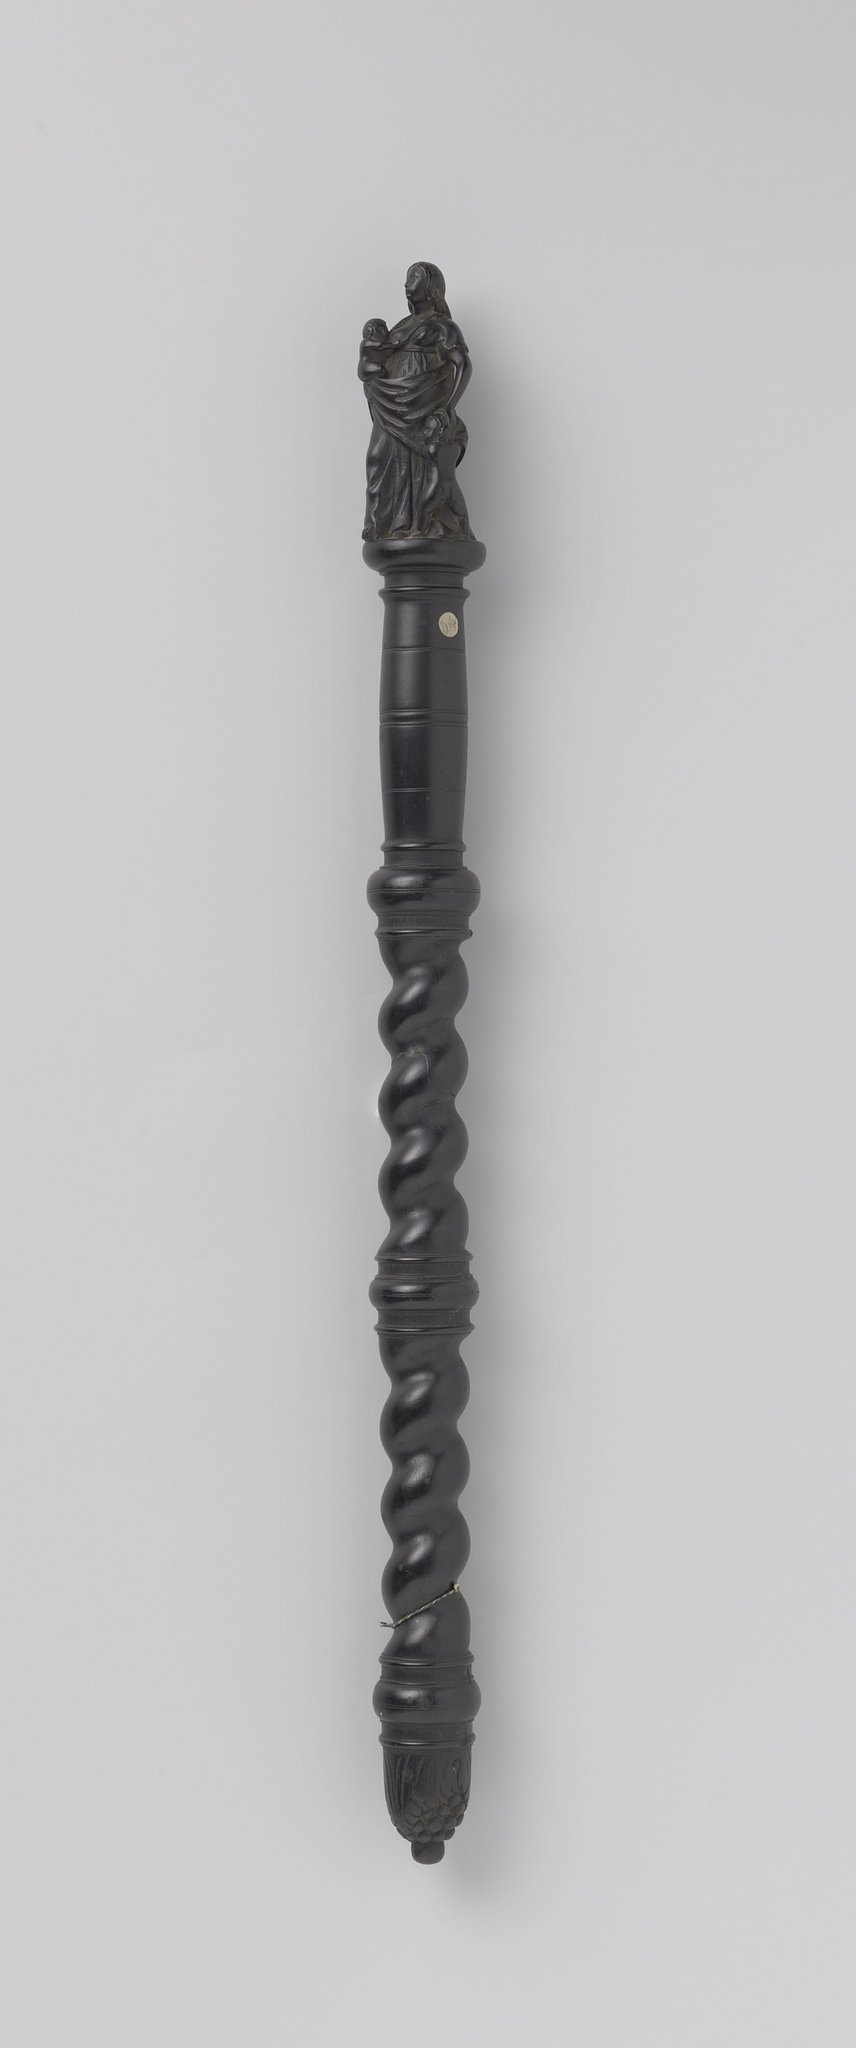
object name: tipstaff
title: Staf van de bode van een liefdadigheidsinstelling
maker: Anonymous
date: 1600-1699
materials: wood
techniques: turning, carving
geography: netherlands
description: Ebbenhouten staf met ronde greep, daaronder twee gedraaide stukken, geheel onder een druiventros. Op de top boven de greep een rondplastiek van een vrouw met een kind op haar arm één aan haar rokken (symbool van liefdadigheid).